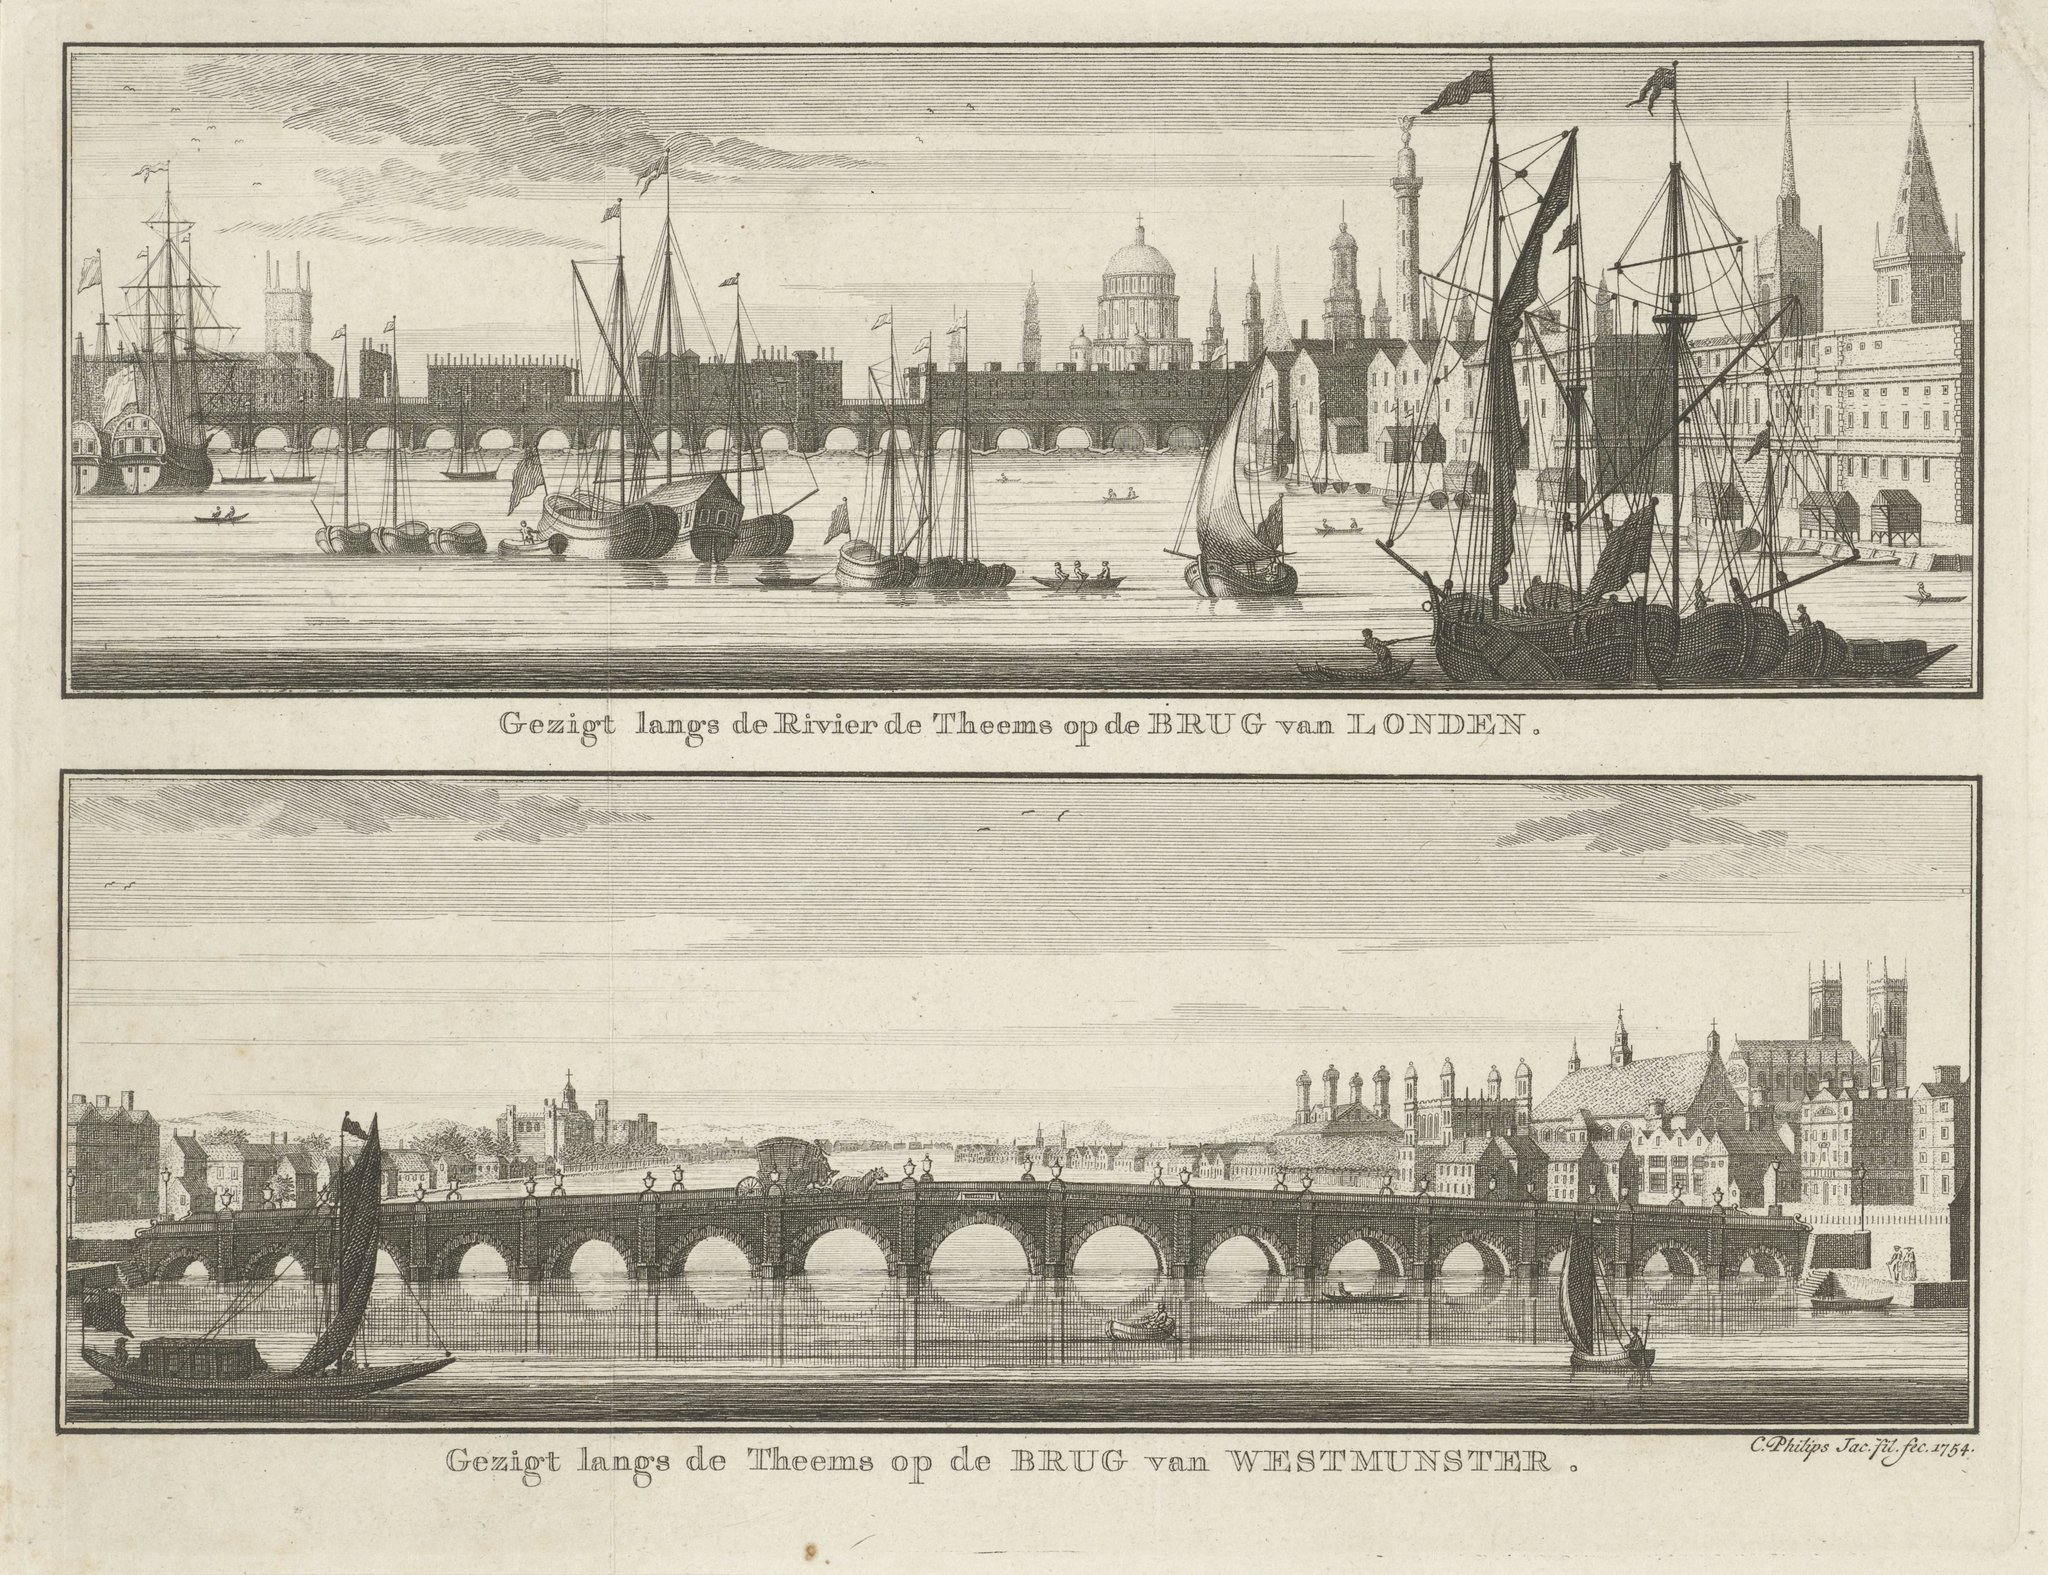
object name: print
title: Gezicht op de London Bridge en op de Westminster Bridge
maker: caspar jacobsz. philips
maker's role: draughtsman, print maker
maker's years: 1732-1789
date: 1754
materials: paper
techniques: etching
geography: amsterdam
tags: bridge, thames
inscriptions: collector's mark: Lugt 2228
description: Twee voorstellingen op één blad. Boven: een gezicht op de Theems en de London Bridge. Onder: een gezicht op de Theems en de Westminster Bridge.